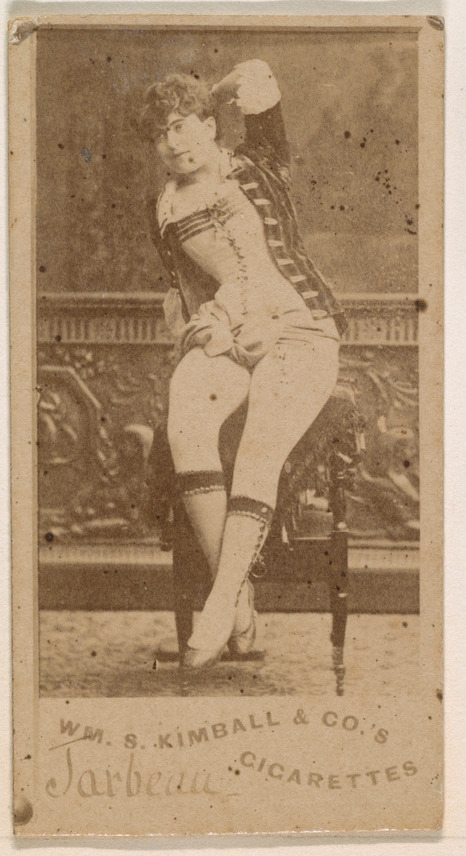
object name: photograph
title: Miss Jarbeau, from the Actresses series (N203) issued by Wm. S. Kimball & Co.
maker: william s. kimball & company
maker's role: publisher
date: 1889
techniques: color lithograph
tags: portraits,women,actresses